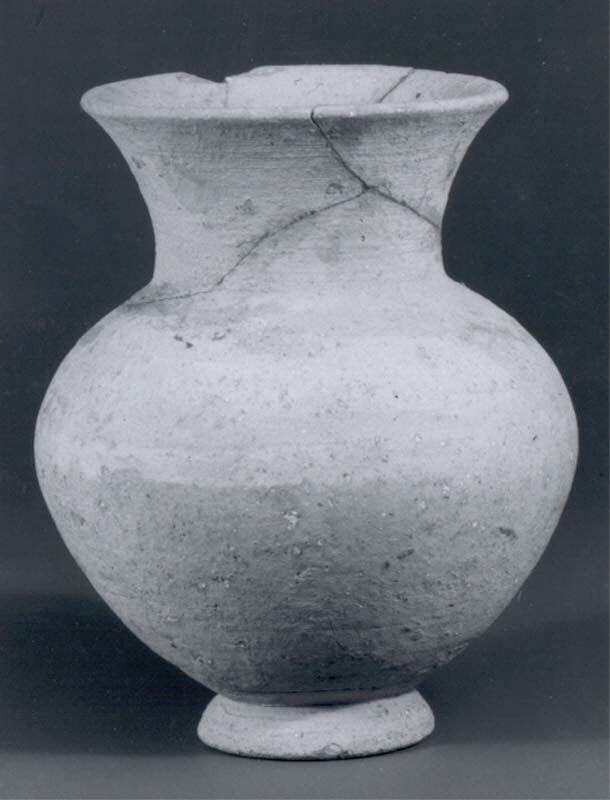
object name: jar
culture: iranian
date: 1700-1501 BCE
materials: ceramic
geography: iran